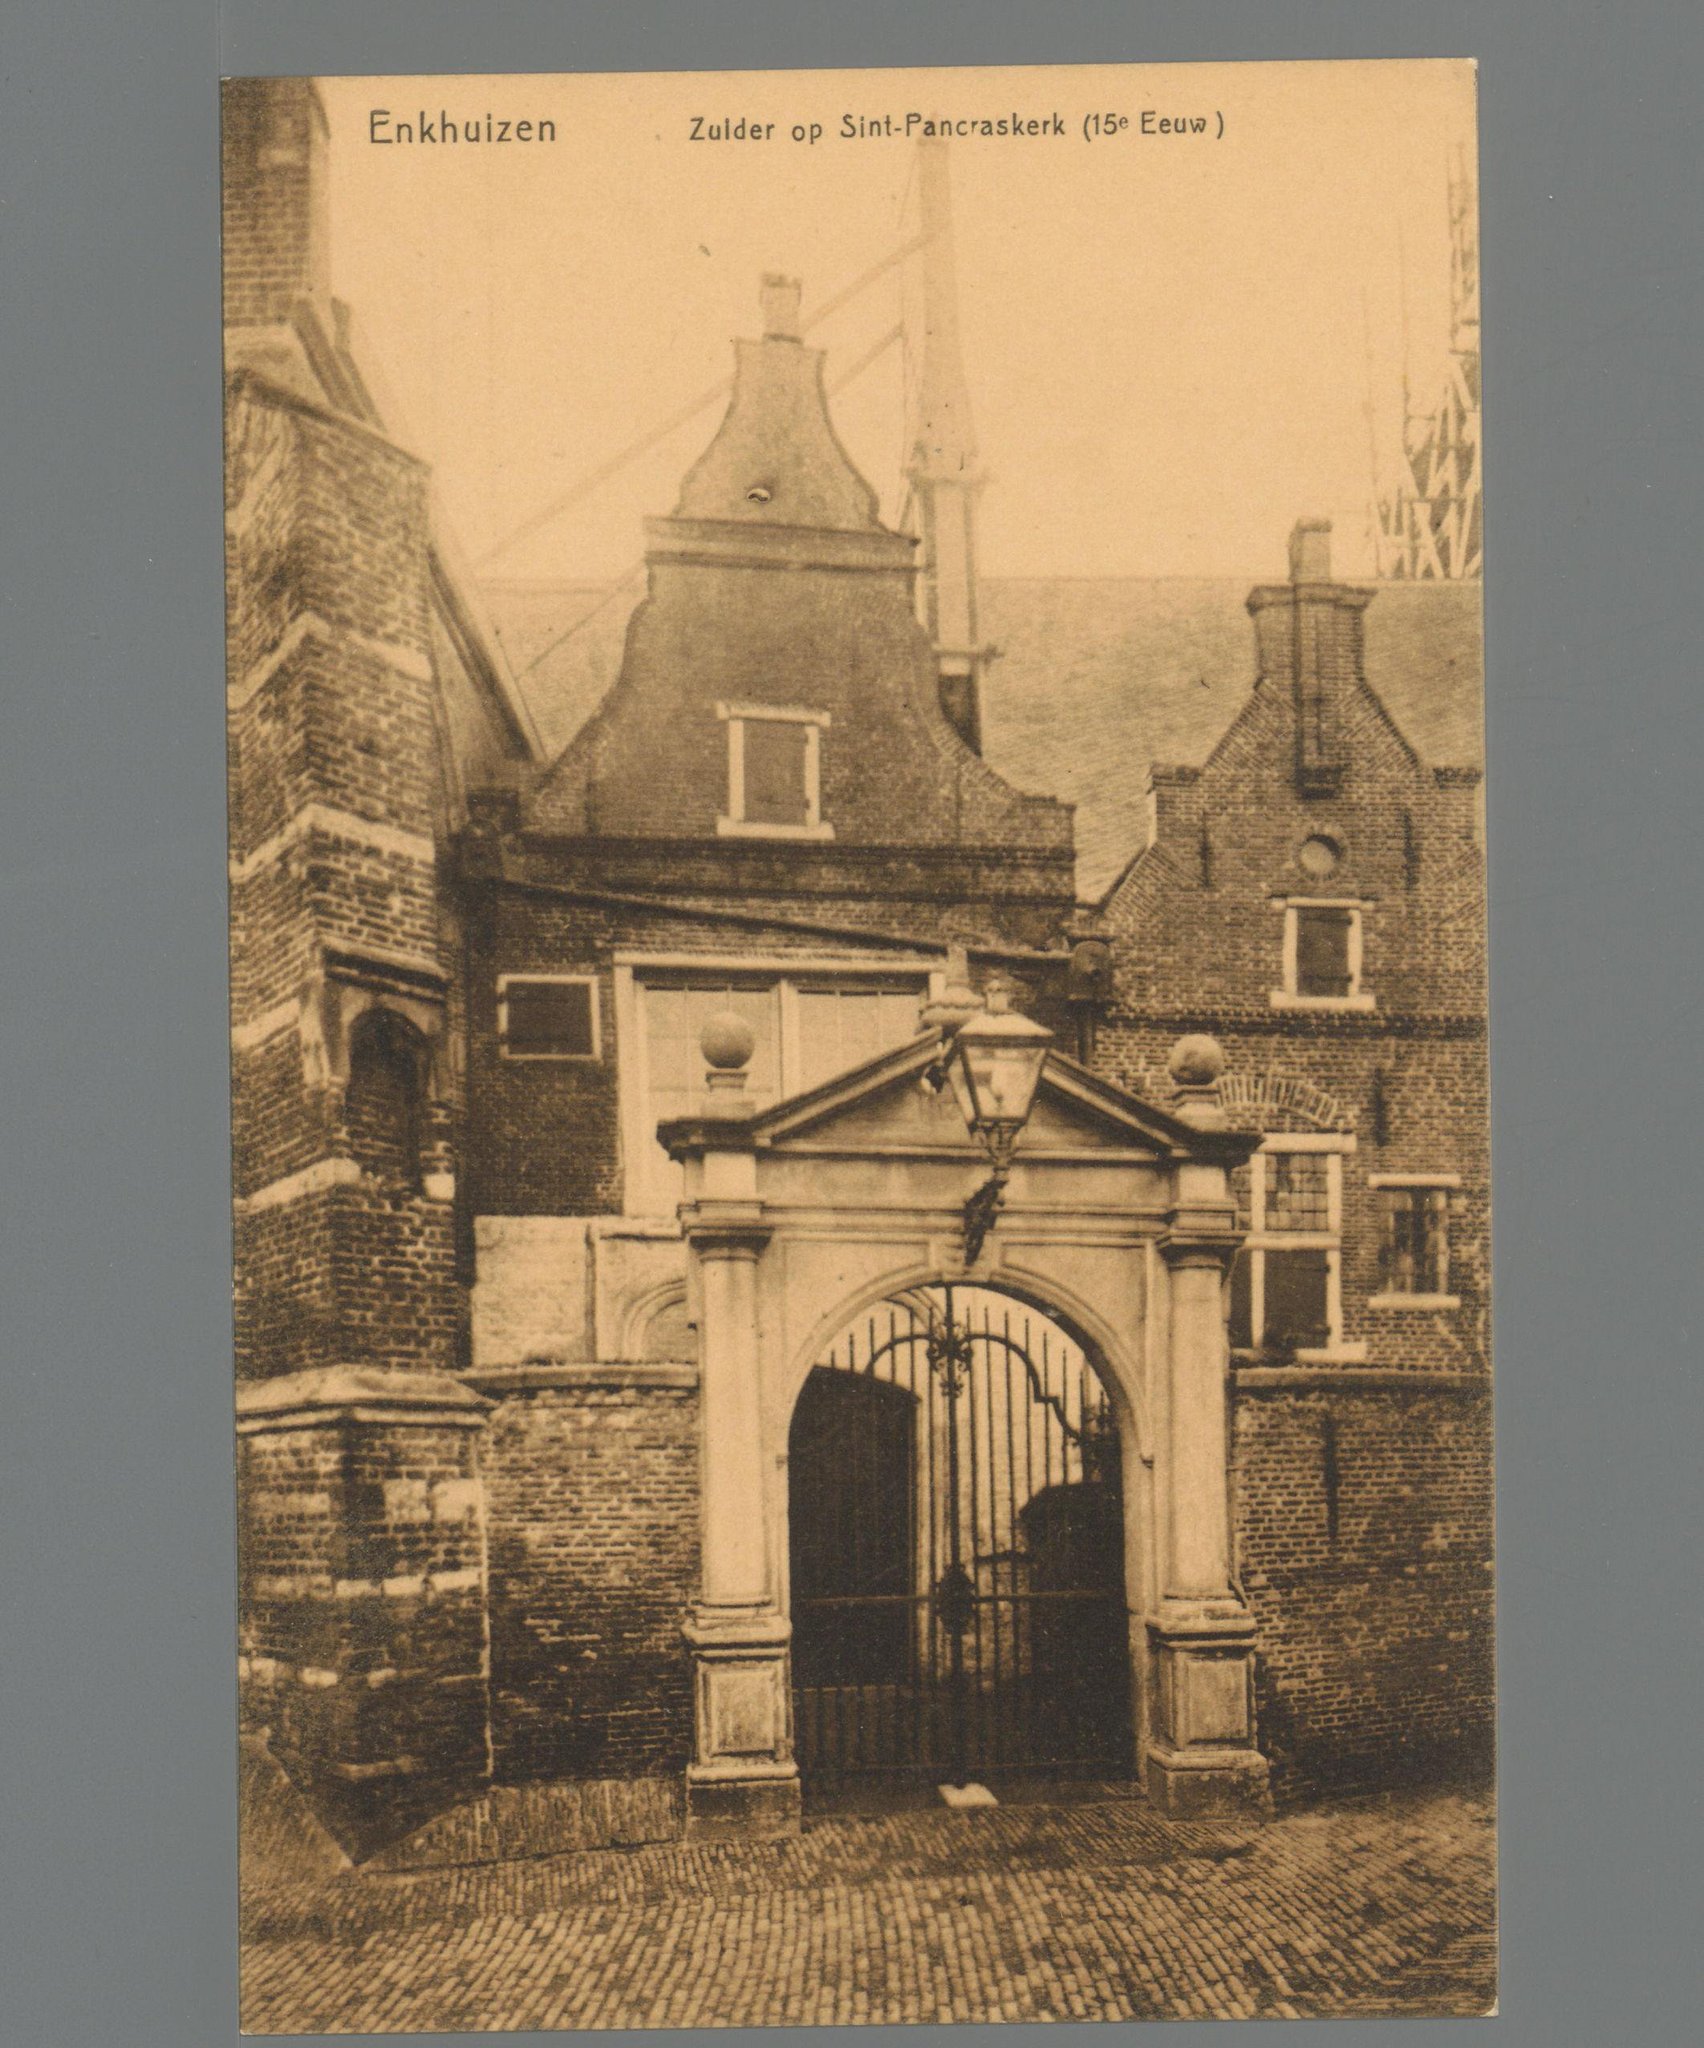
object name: ansichtkaart, prentbriefkaart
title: Enkhuizen. Zuider op Sint-Pancraskerk (15e eeuw)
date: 1906-1920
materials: cardboard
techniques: photograph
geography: enkhuizen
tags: gate, entrance, parts of church exterior and annexes, enkhuizen